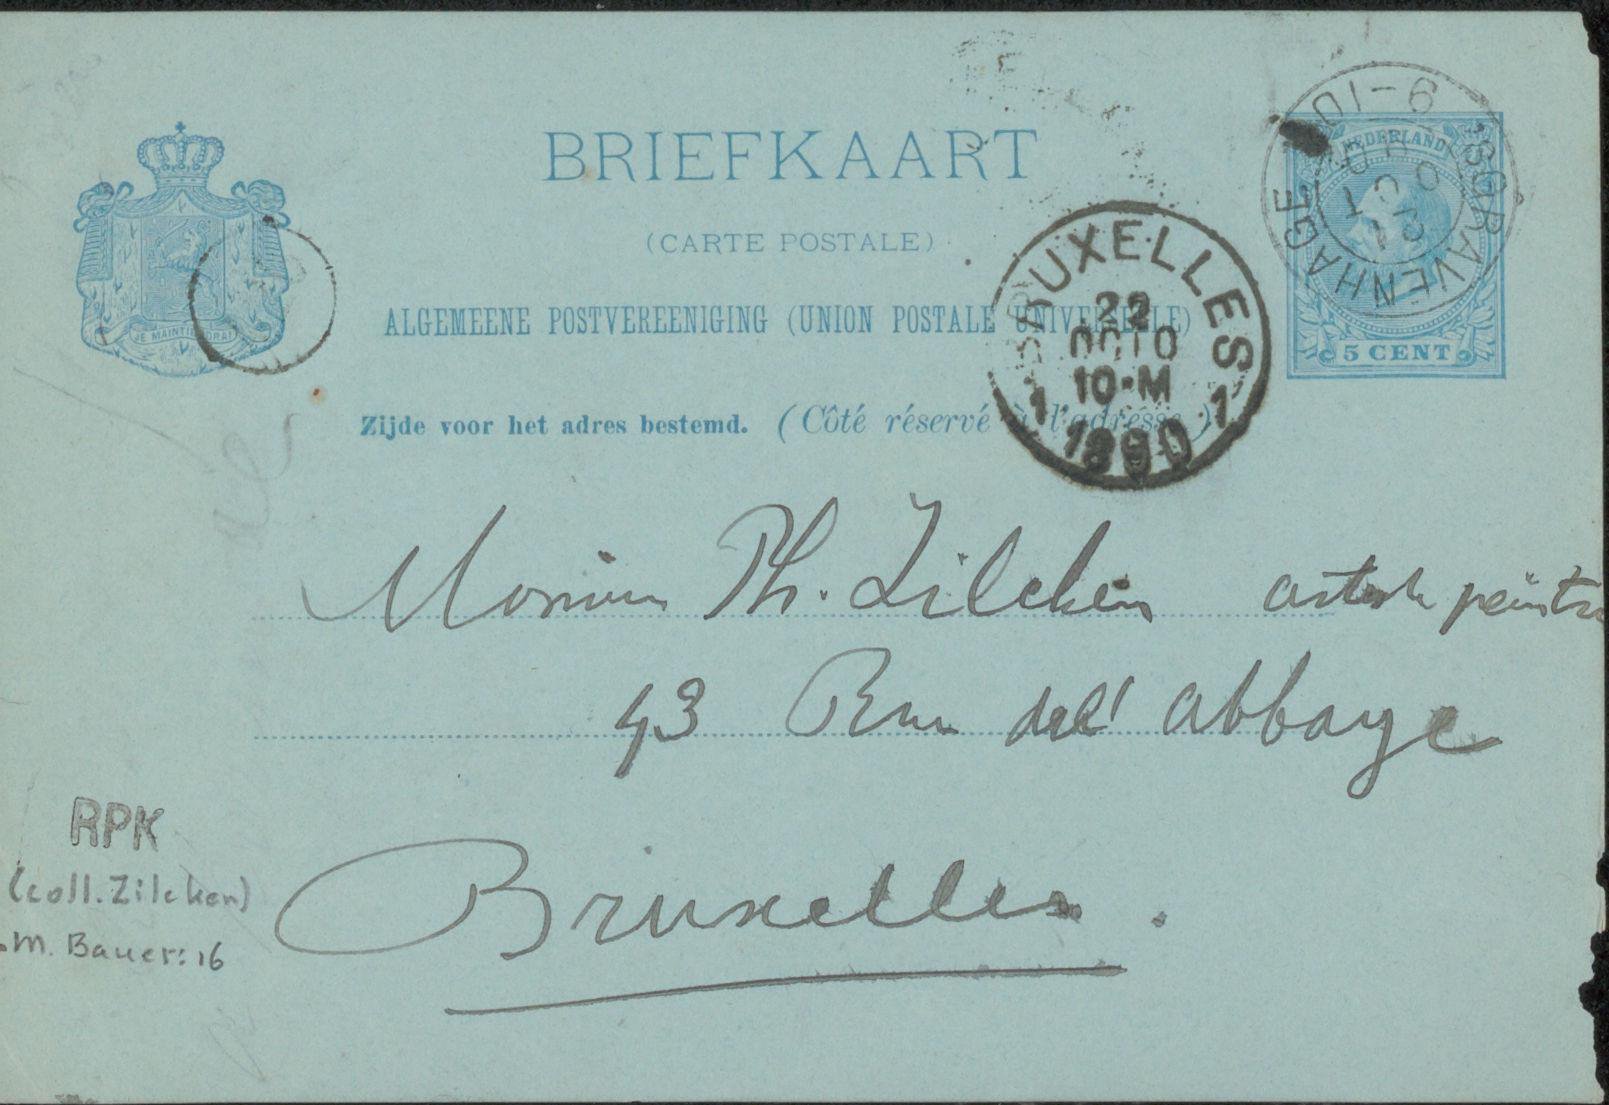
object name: postcard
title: Briefkaart aan Philip Zilcken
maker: marius bauer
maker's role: draughtsman, print maker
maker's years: 1867-1932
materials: cardboard, ink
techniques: pen, writing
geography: brussels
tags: eduard karsen, martinus mouton, painter, philip zilcken, etching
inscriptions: collector's mark: ‘RPK’